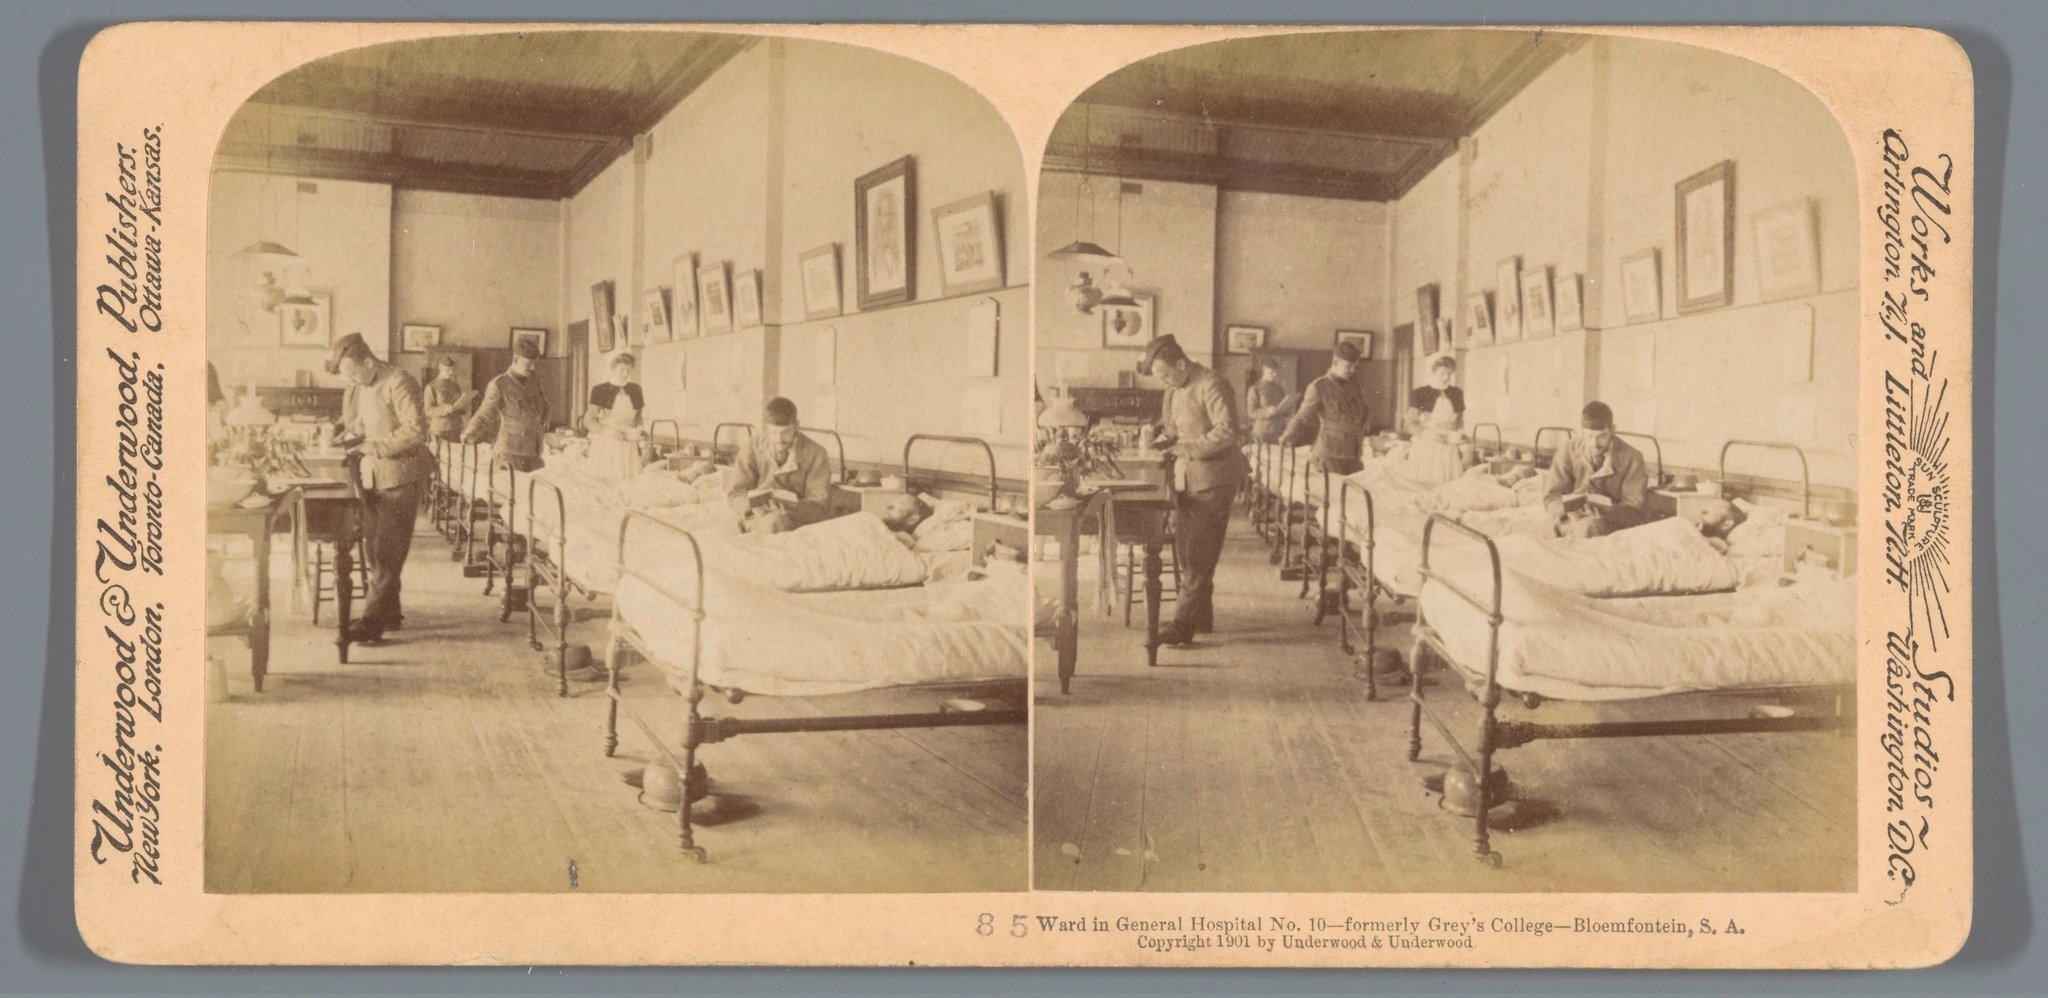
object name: stereograph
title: Interieur van een ziekenzaal in een militair ziekenhuis in Bloemfontein, Zuid-Afrika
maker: Anonymous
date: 1901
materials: cardboard, paper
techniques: albumen print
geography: new york city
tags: the soldier; the soldier's life, ward; room (in hospital)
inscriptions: inscription, number: ‘85’, inscription: ‘Works and Studios ~/ Arlington, N.J. Littleton, N.H. Washington, D.C.’, copyright notice: ‘Copyright 1901 by Underwood & Underwood.’